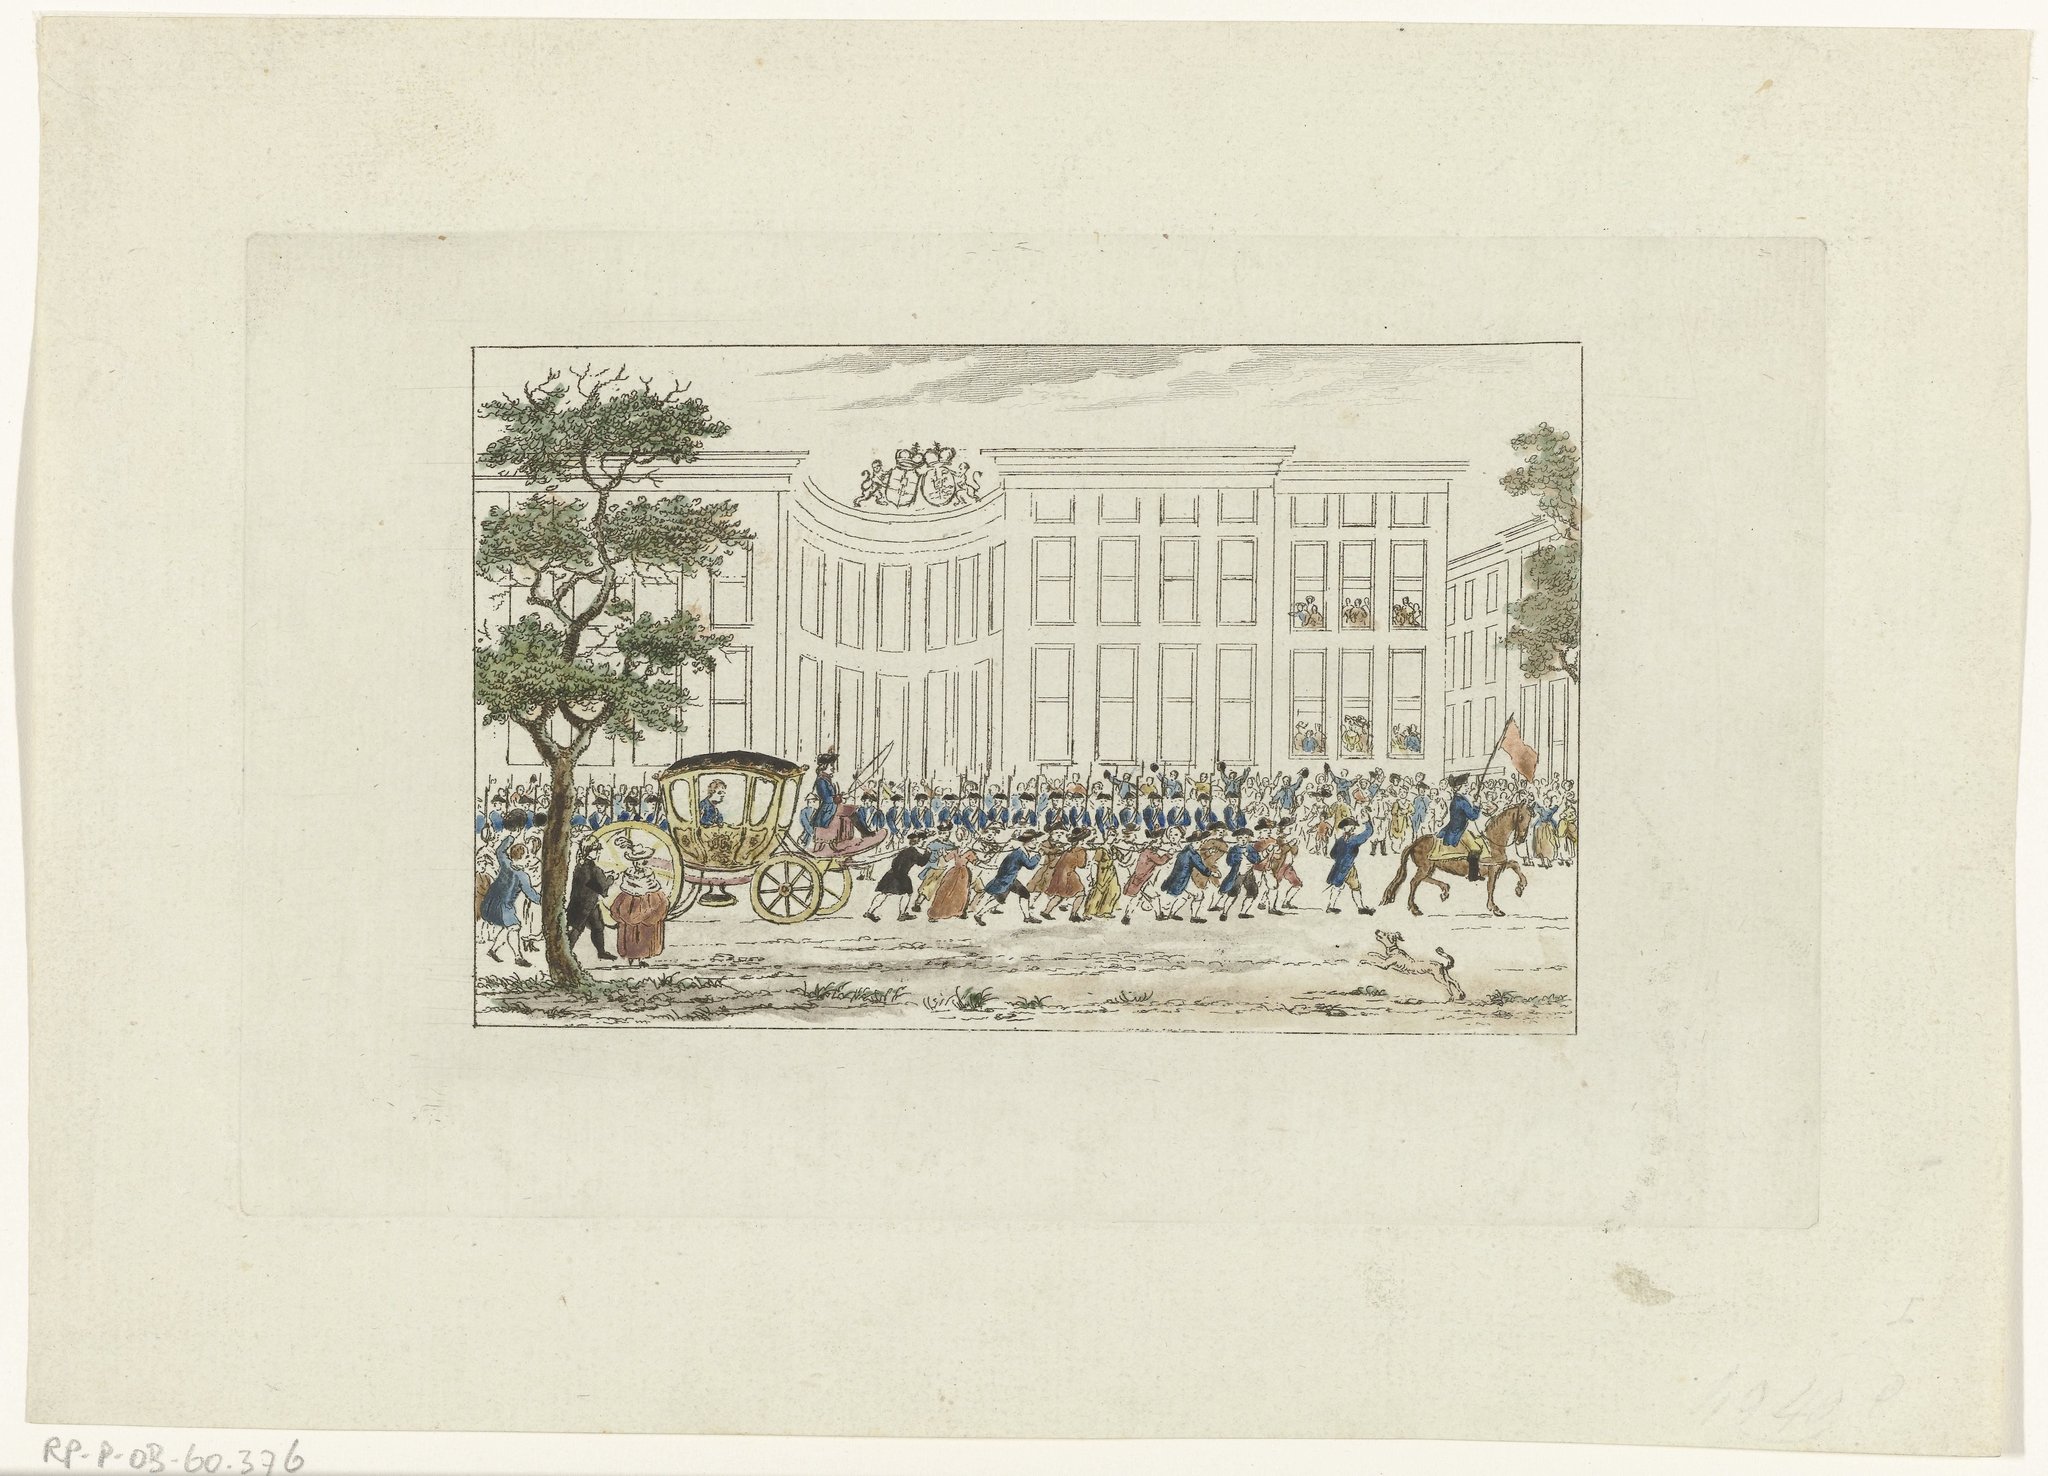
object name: print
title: Inhaling van de prins van Oranje, 1787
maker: mathias de sallieth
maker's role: print maker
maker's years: 1749-1791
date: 1787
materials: paper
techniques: etching, hand coloring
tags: the hague, william v (prince of orange), public festivities at other royal events, not meant or mentioned above, human being(s) drawing or pushing a vehicle not usually propelled by manpower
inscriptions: collector's mark: Lugt 2228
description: Inhaling van de prins van Oranje door de burgerij te Den Haag, 20 september 1787. De koets met stadhouder Willem V wordt door mannen en vrouwen over de weg langs het Paleis van Nassau-Weilburg getrokken.